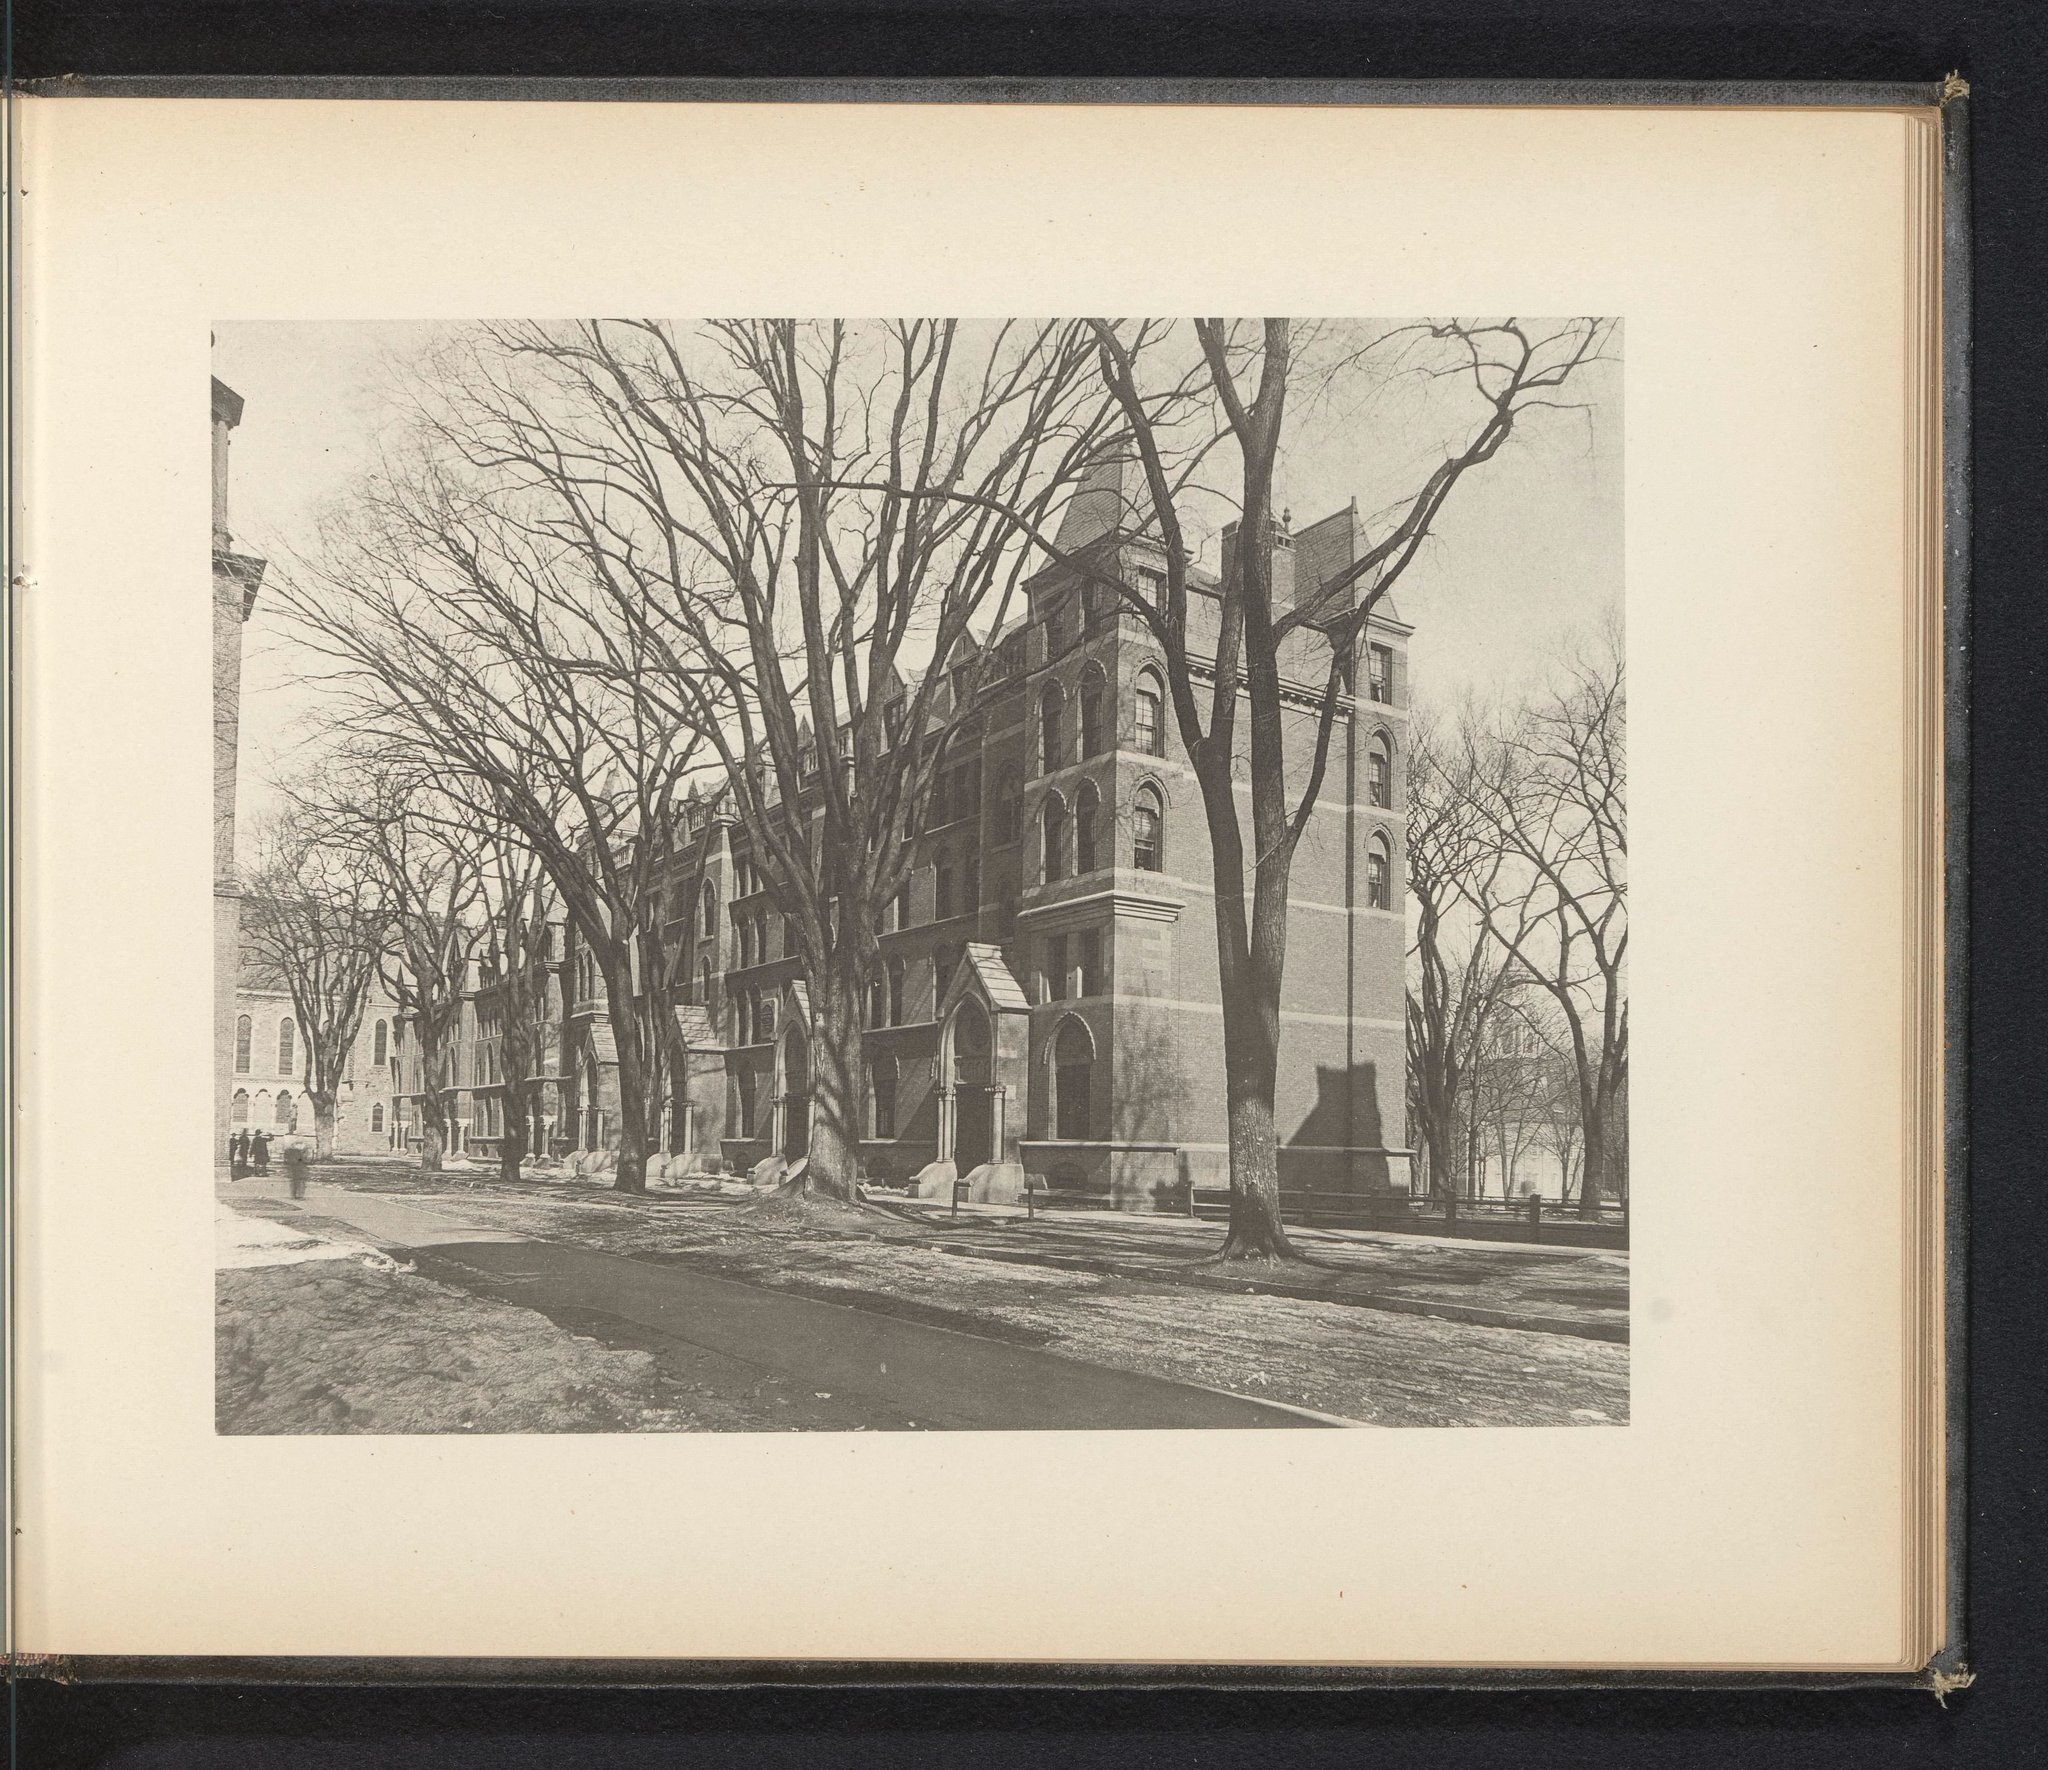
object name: page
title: Exterieur van Lawrence Hall en Farnam Hall van Yale University te New Haven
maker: Anonymous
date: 1895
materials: paper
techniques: photograph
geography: new haven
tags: university building, college, façade (of house or building)